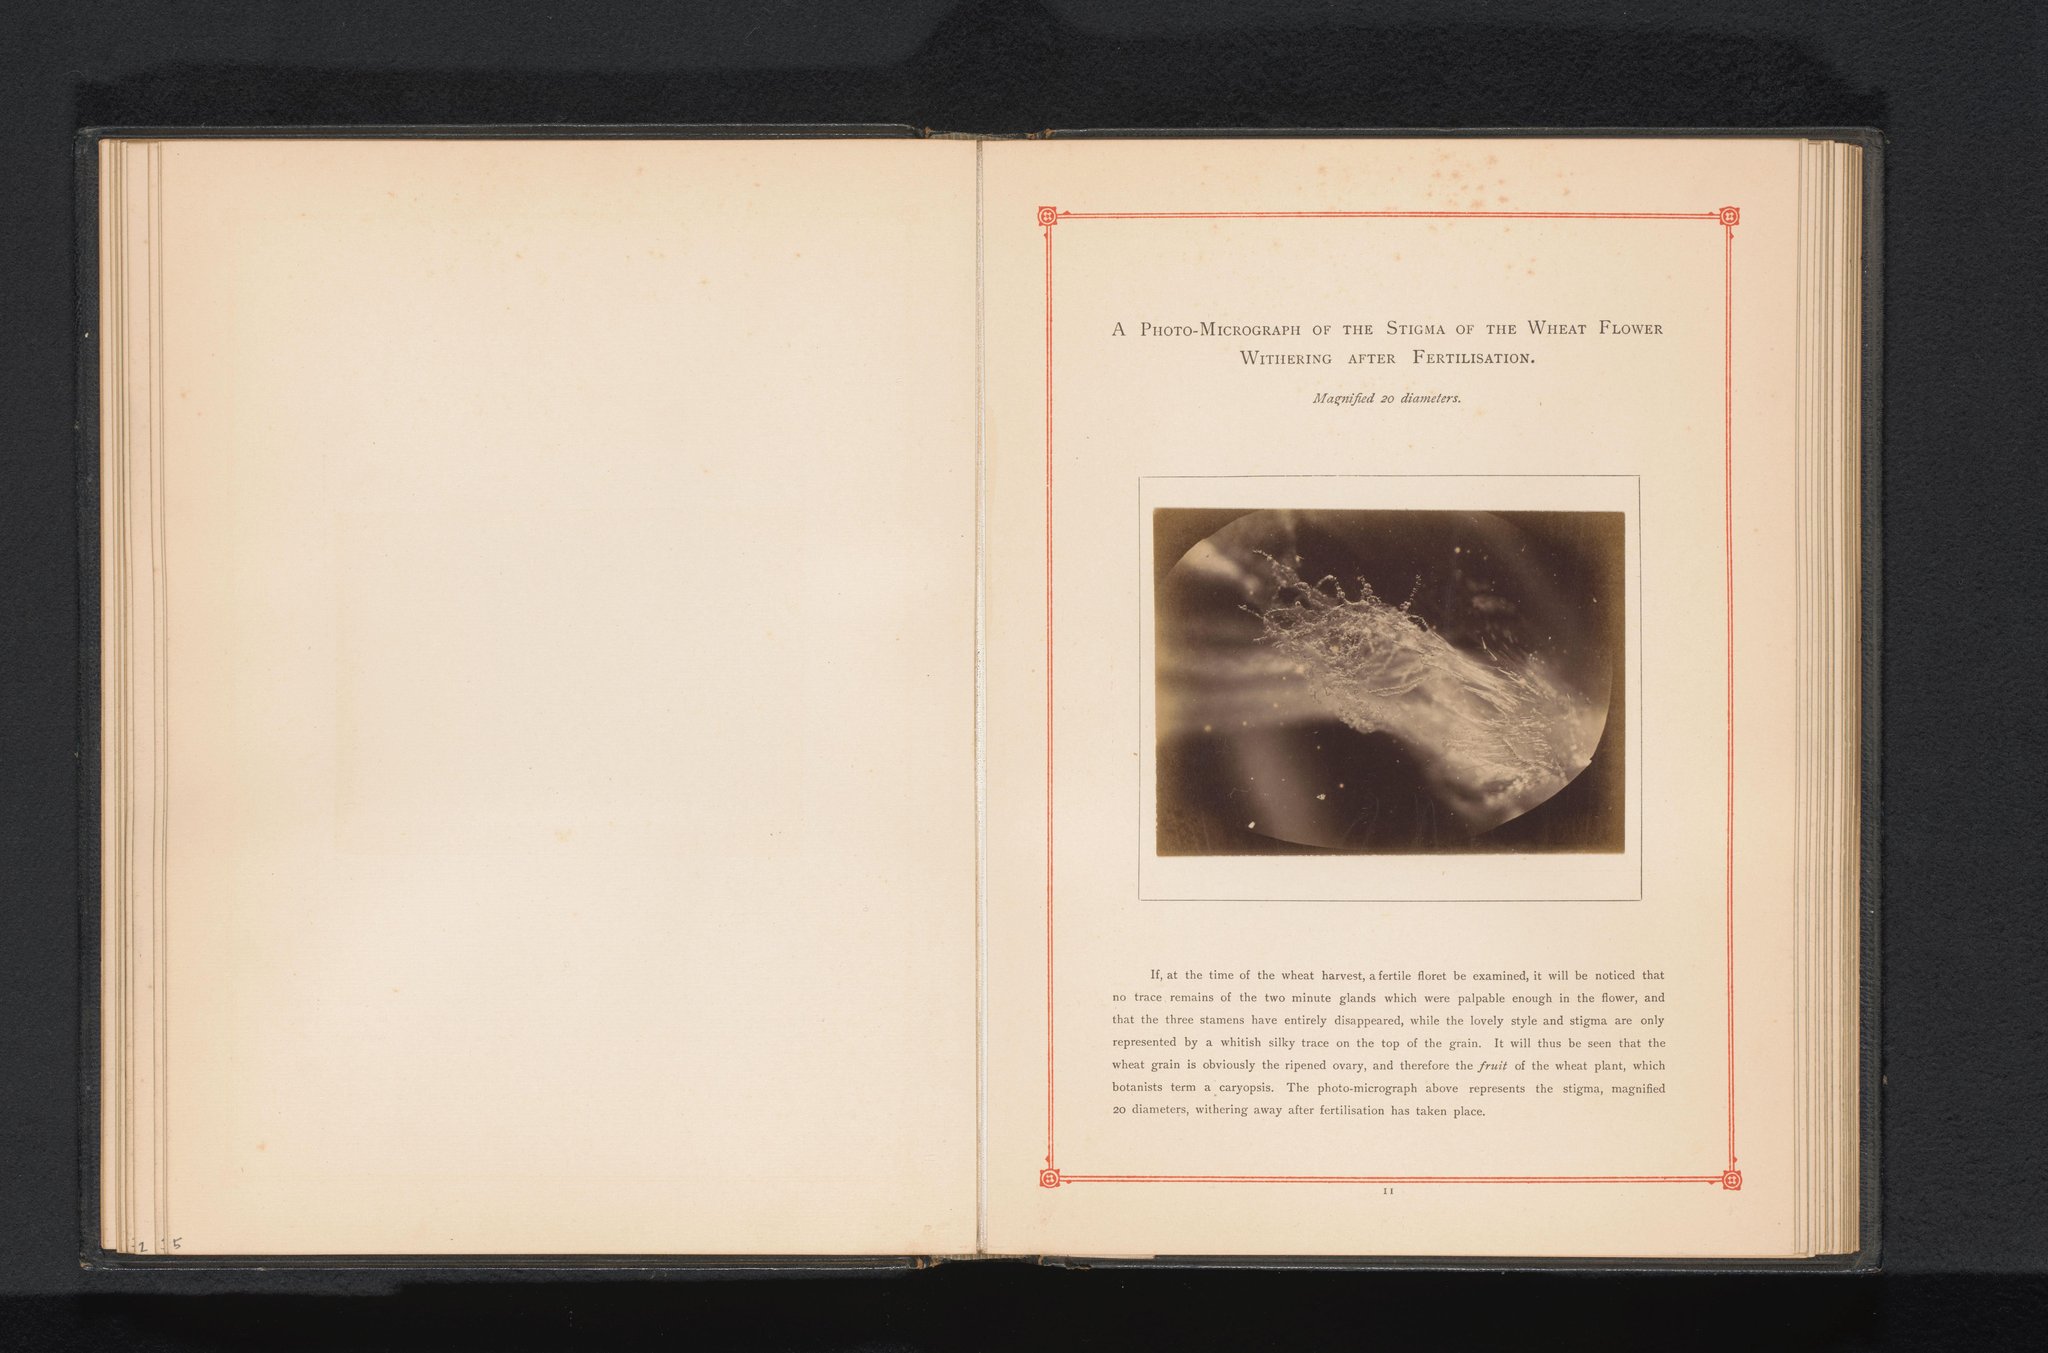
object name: page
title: Microscoopopname van een stempel van een tarweaar na de bevruchting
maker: robert w. dunham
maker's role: fotograaf, wetenschapper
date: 1882-1892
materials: photographic support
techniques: albumen print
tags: plants and herbs: wheat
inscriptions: inscription: ‘Magnified 20 diameters.’